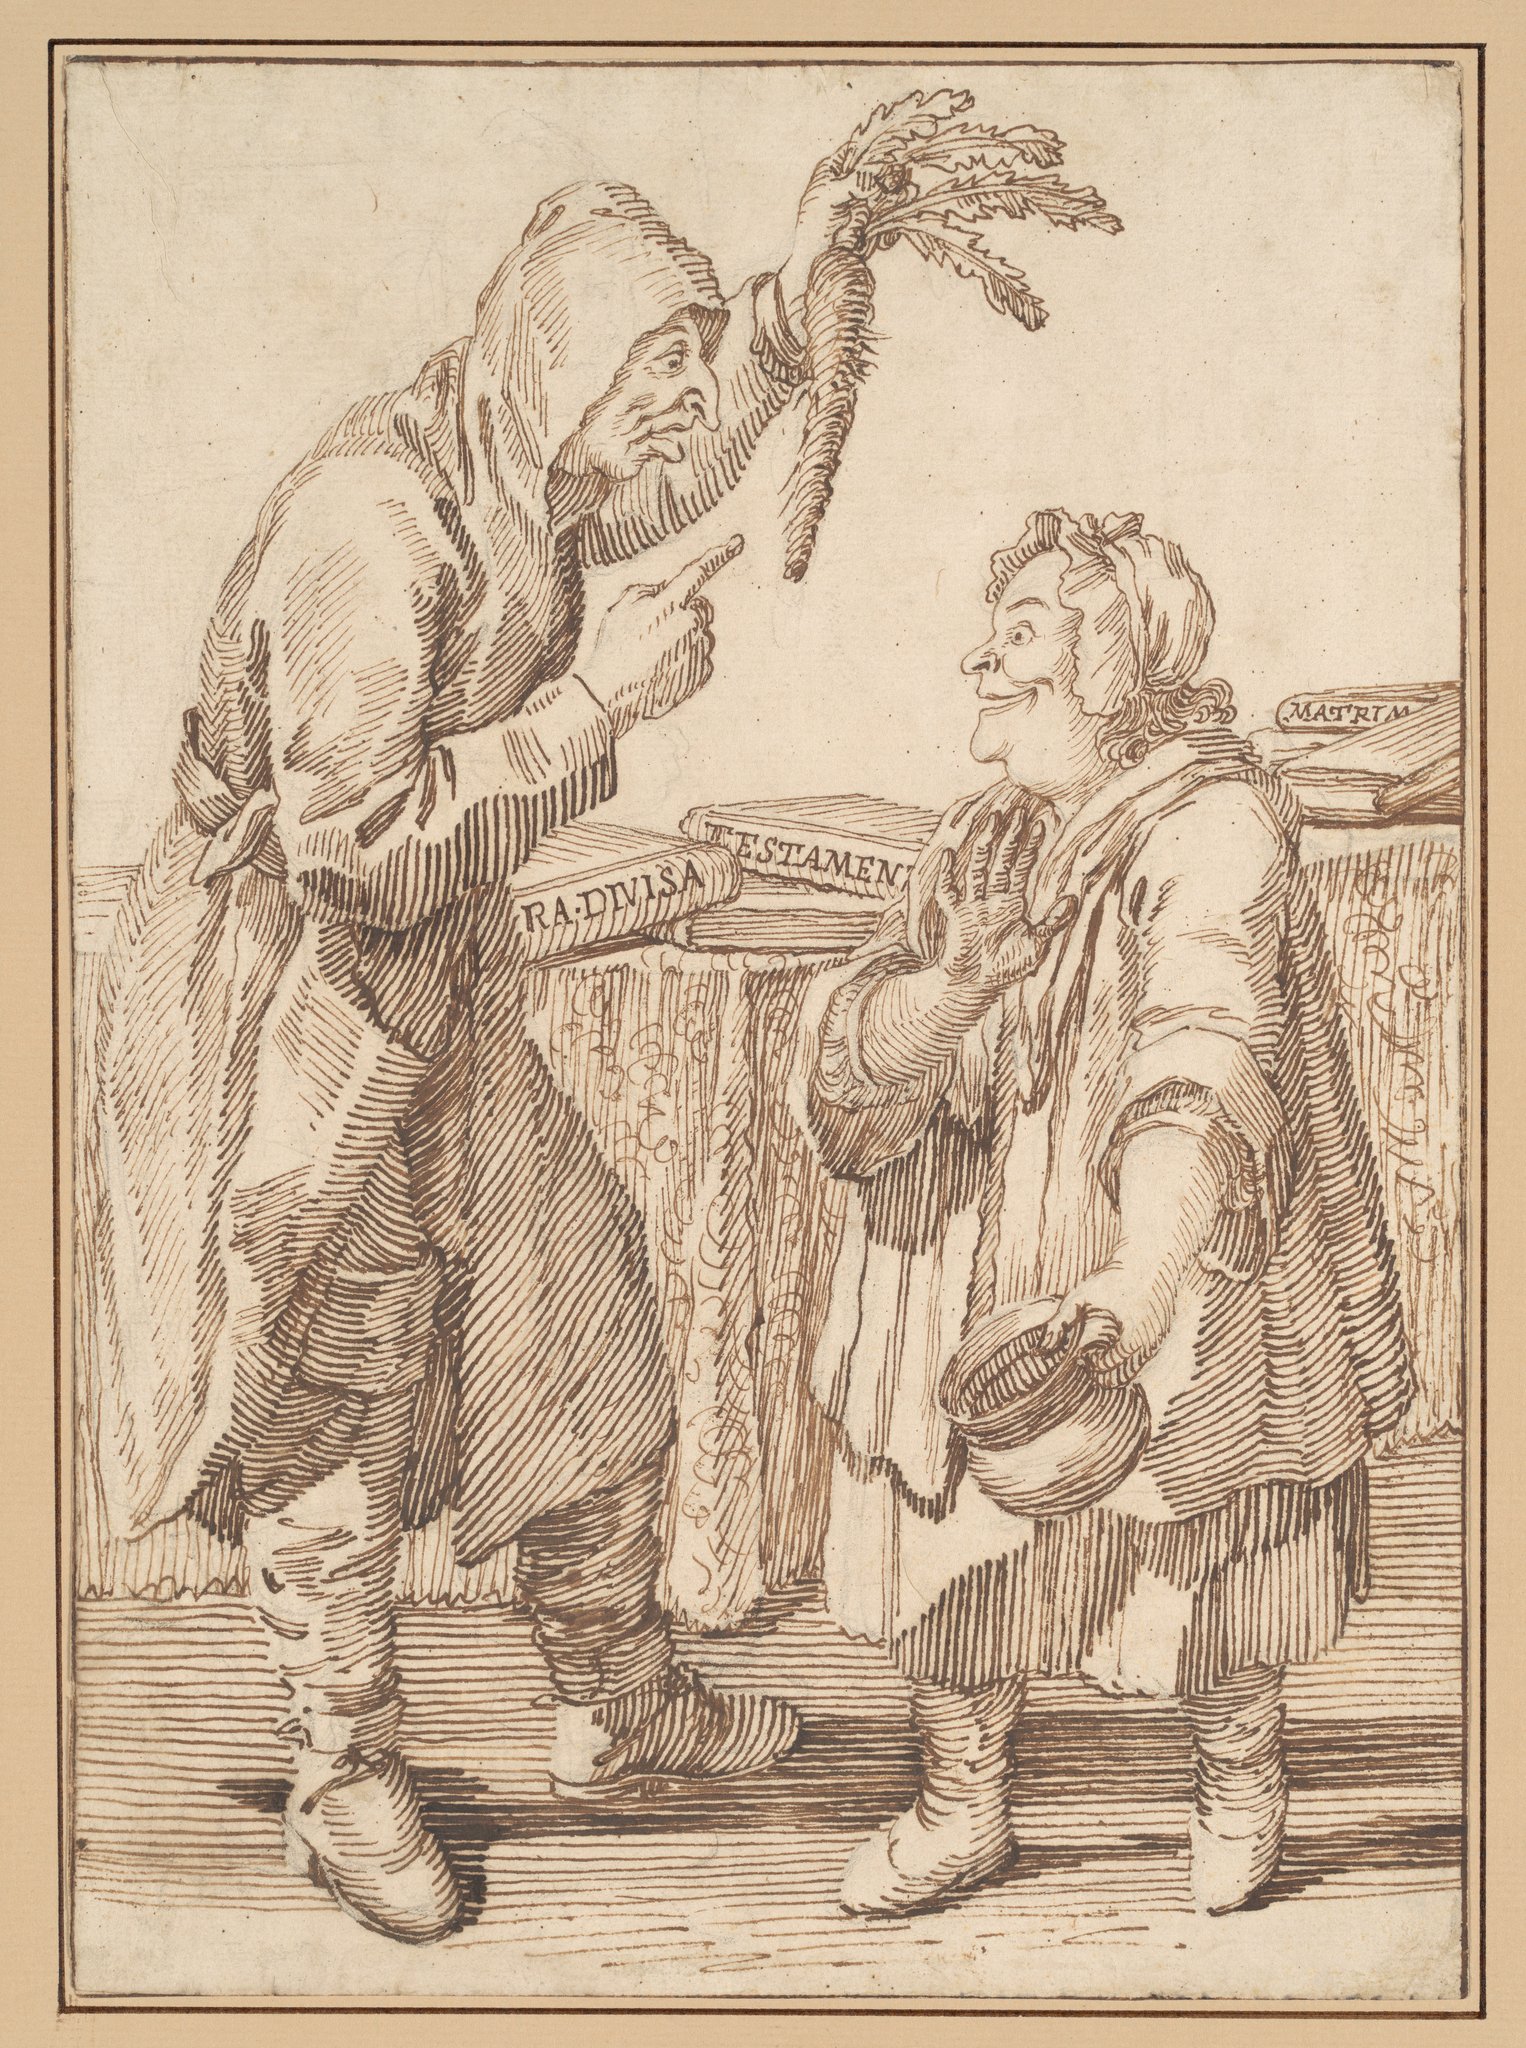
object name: drawing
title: A Monk with a Carrot and a Woman with a Chamber Pot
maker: pier leone ghezzi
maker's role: artist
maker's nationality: italian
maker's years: 1674-1755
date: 1667-1766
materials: ink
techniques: pen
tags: carrots,women,monks